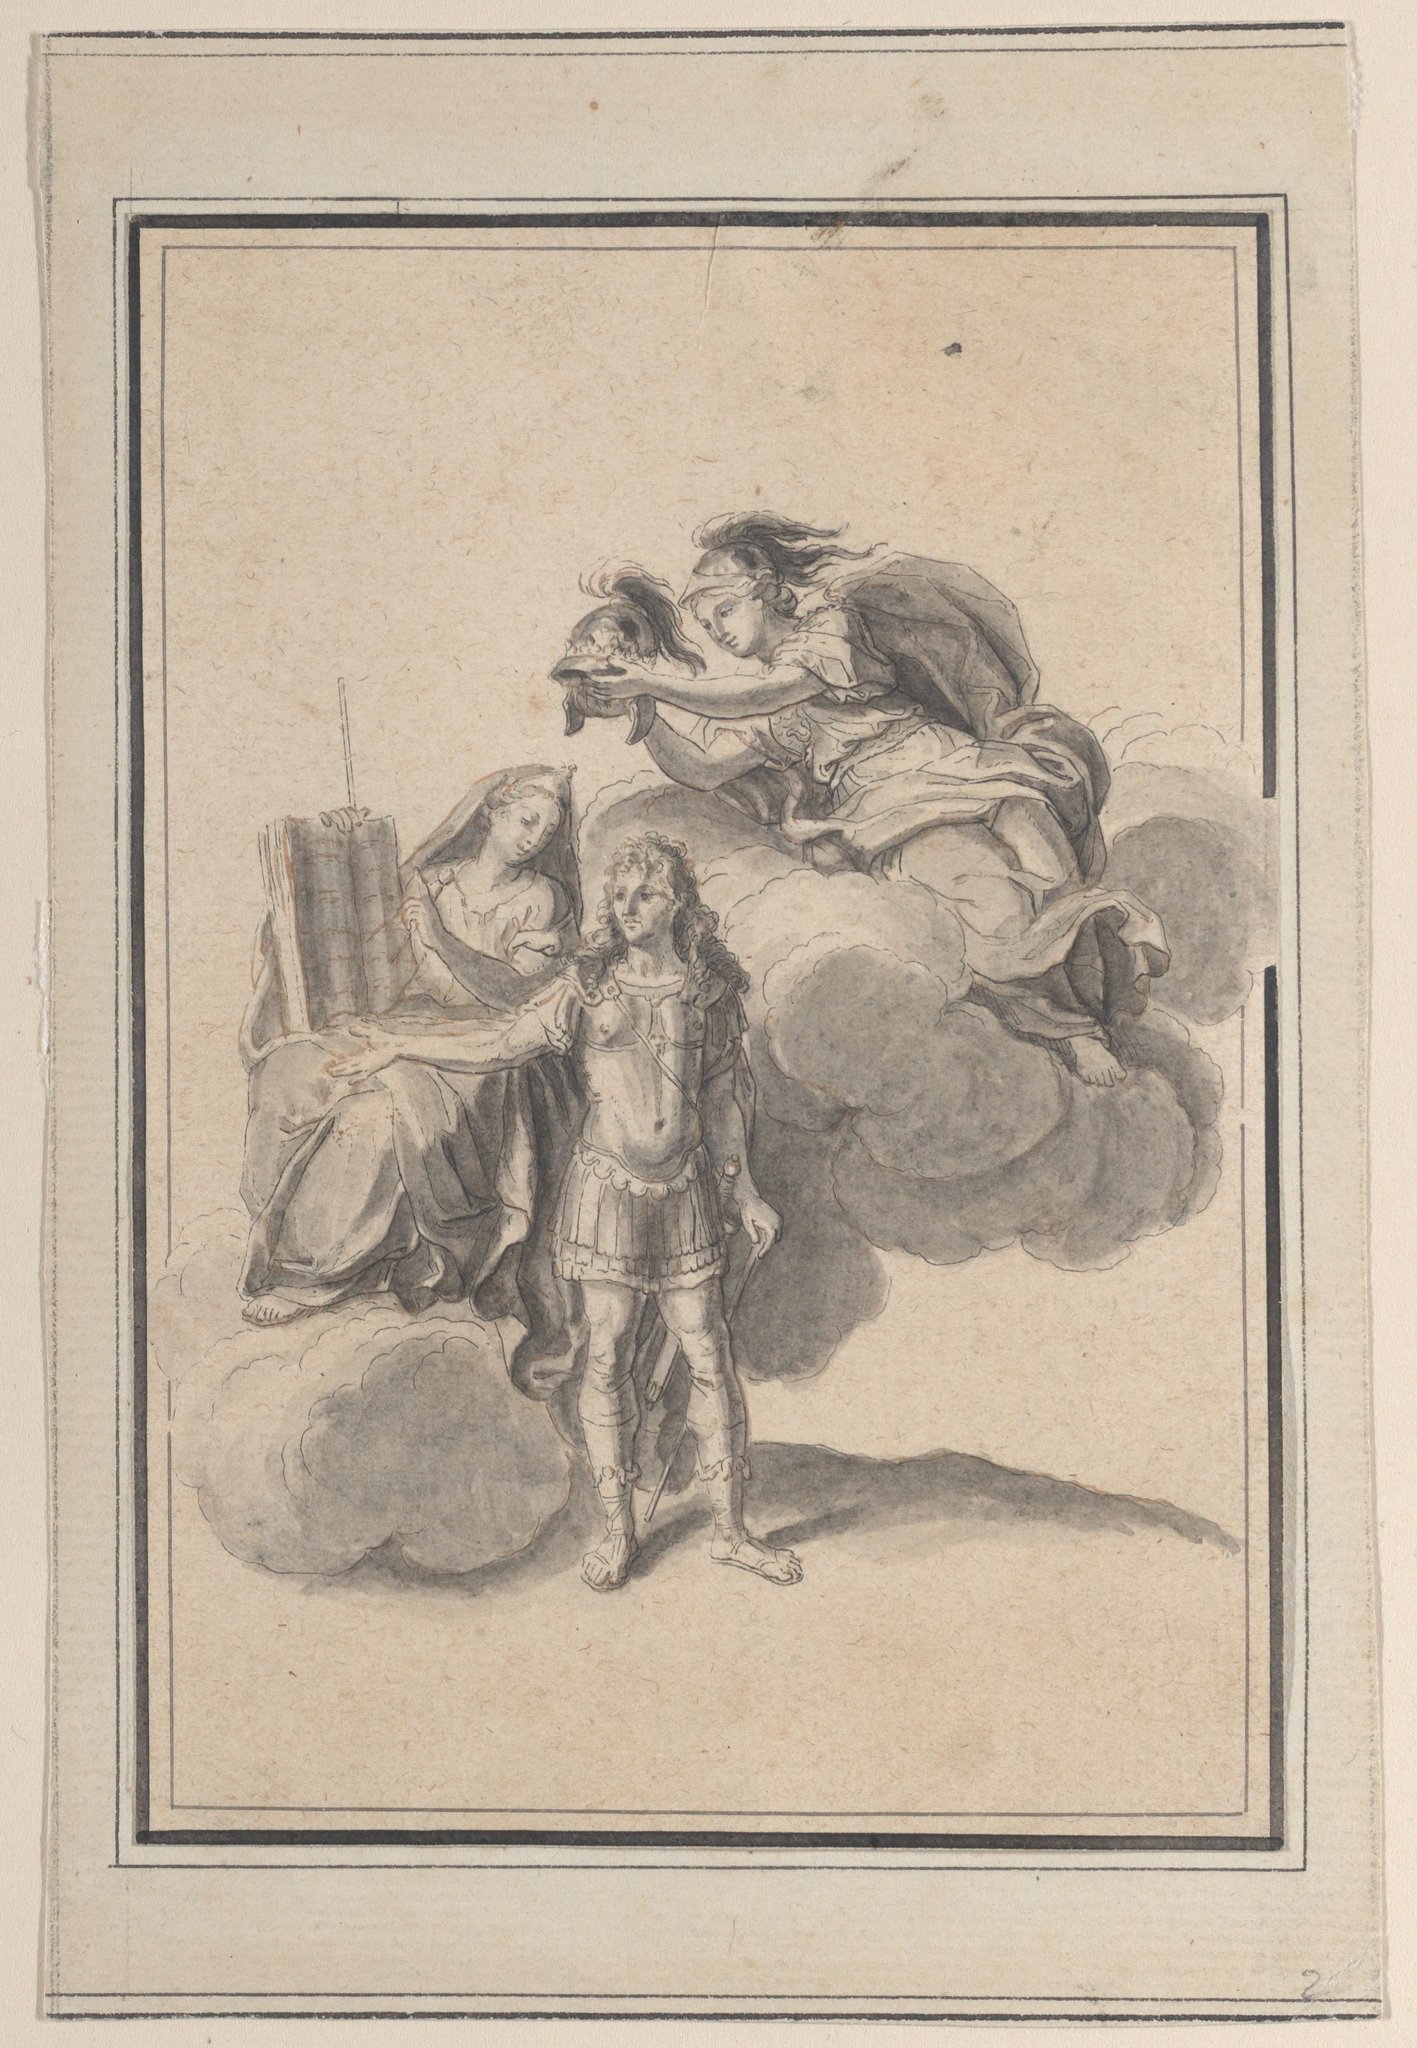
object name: drawing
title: Vignette from the Galerie des Glaces, Versailles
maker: bernard picart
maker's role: artist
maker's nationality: french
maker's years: 1673-1733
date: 1701-1733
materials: ink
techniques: brush, pen, wash